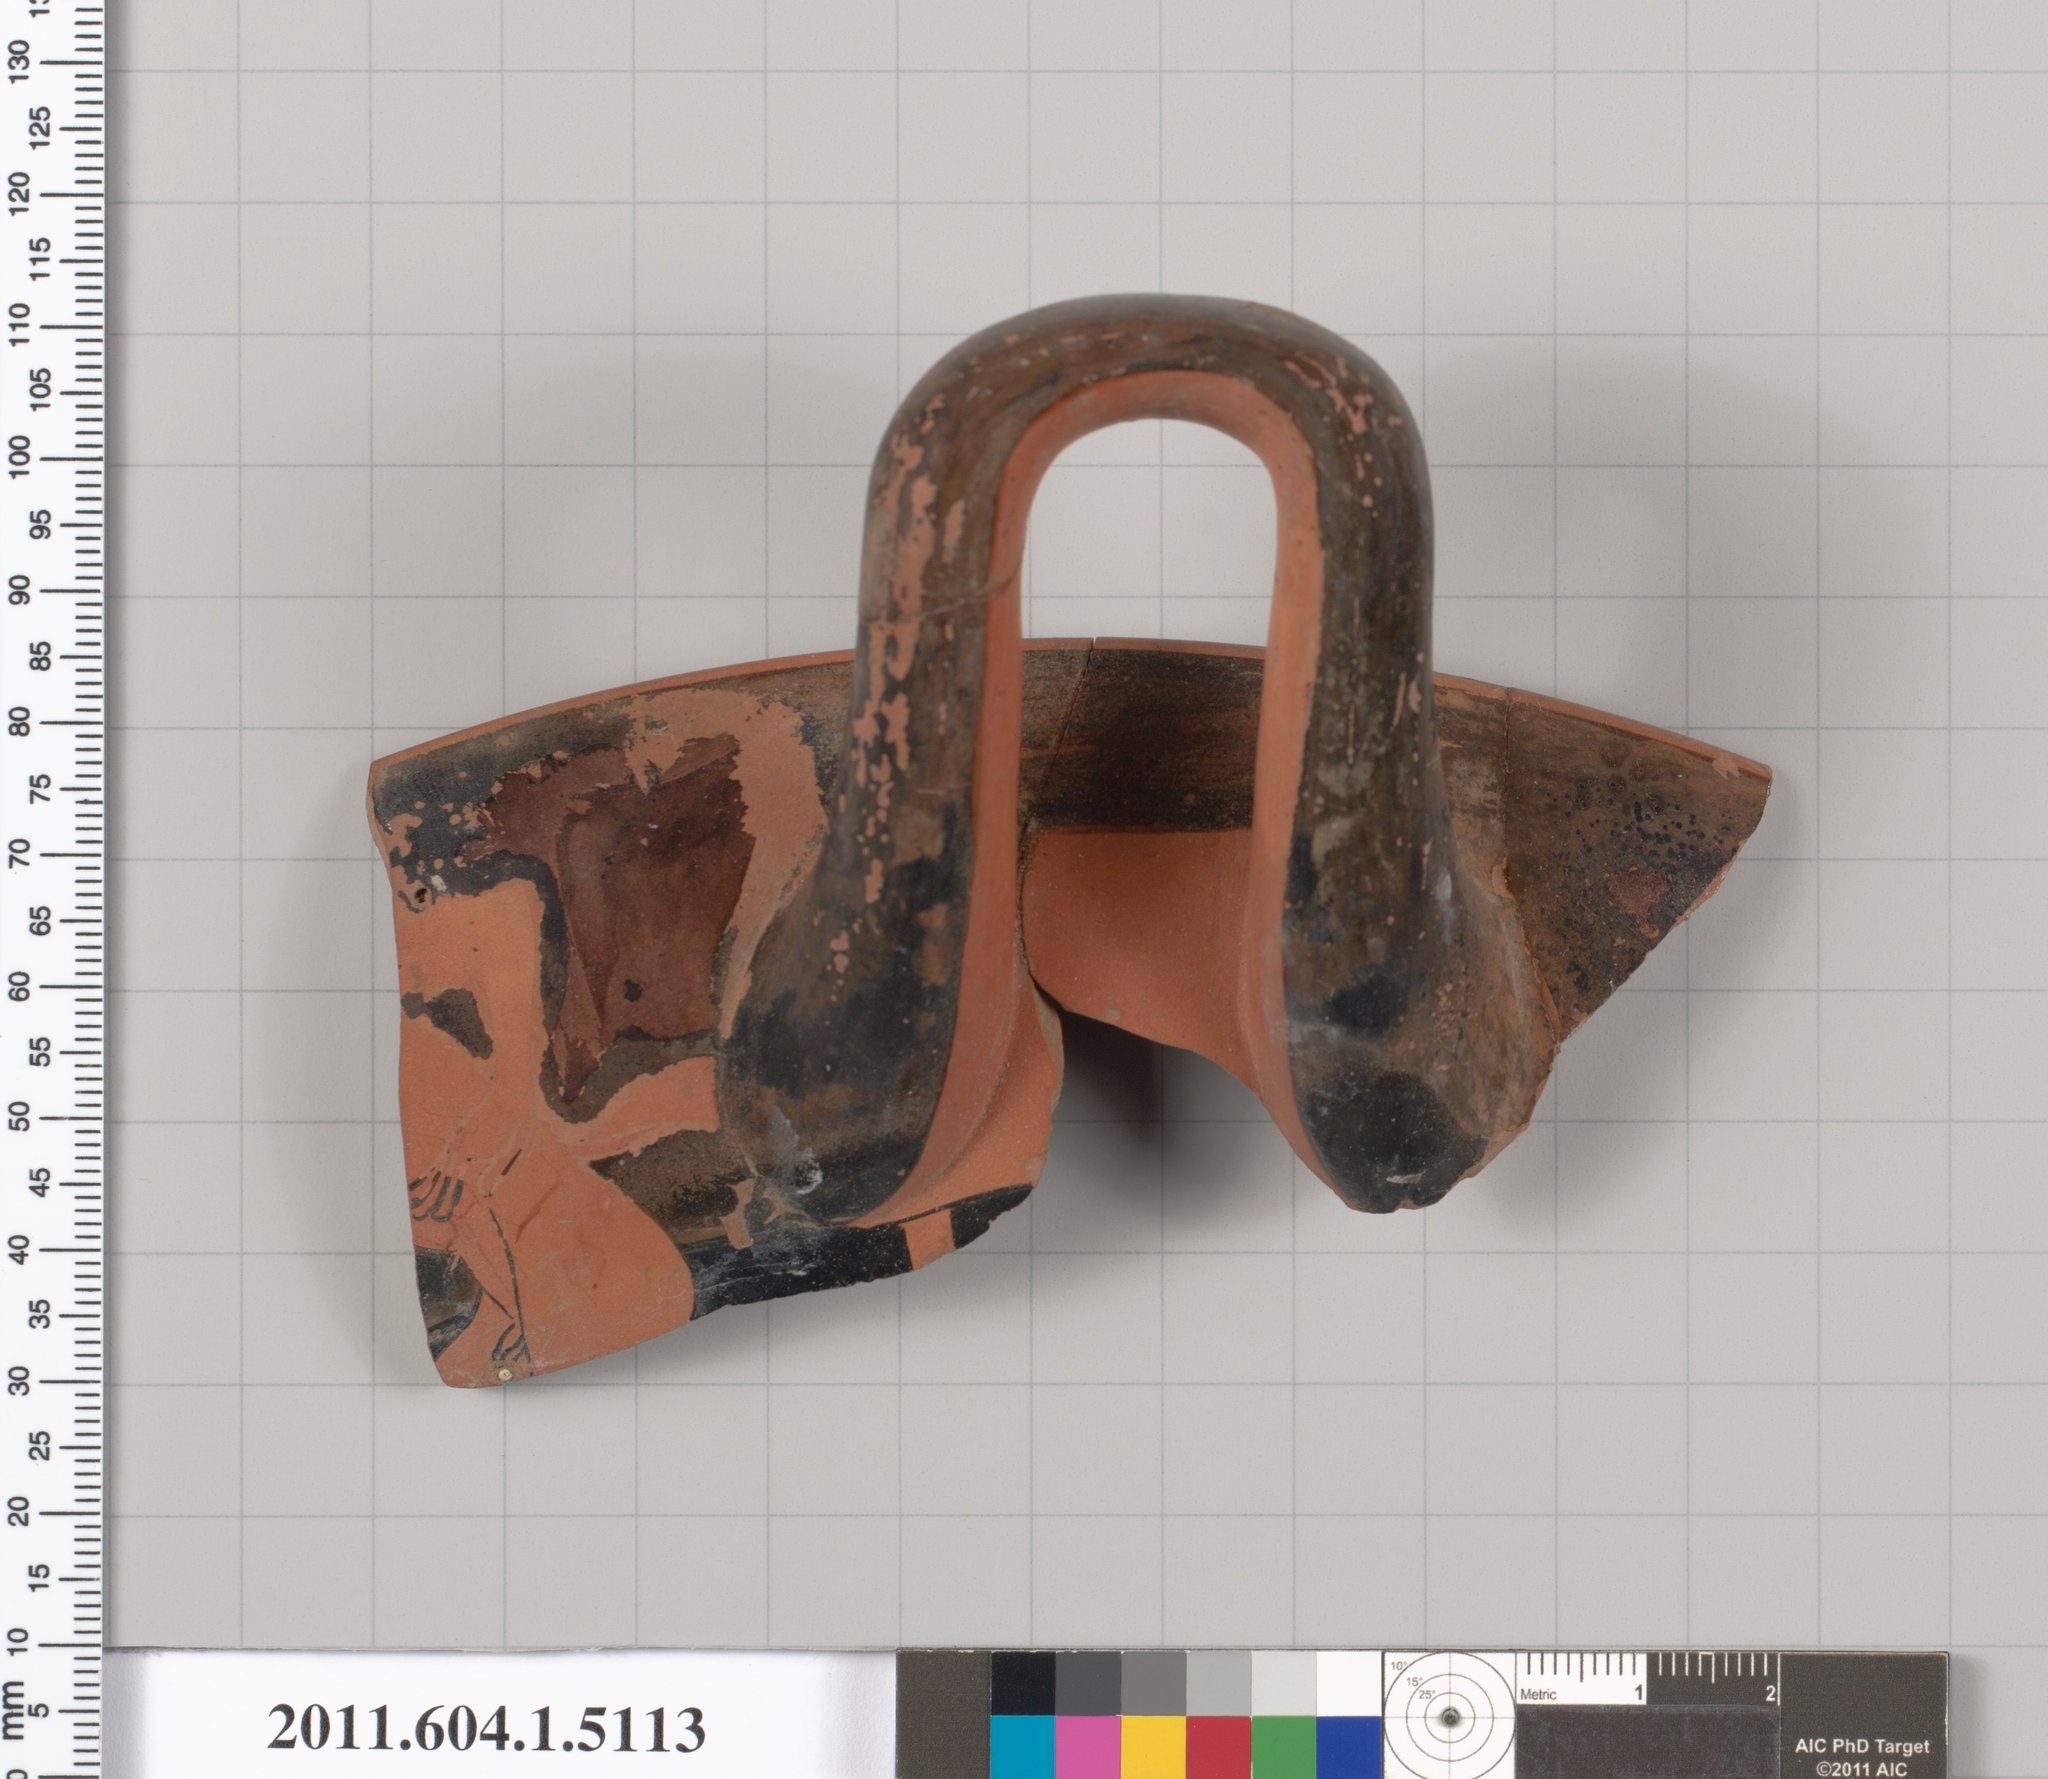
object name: kylix fragment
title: Terracotta rim fragment of a kylix (drinking cup)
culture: greek, attic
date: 500-470 BCE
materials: terracotta